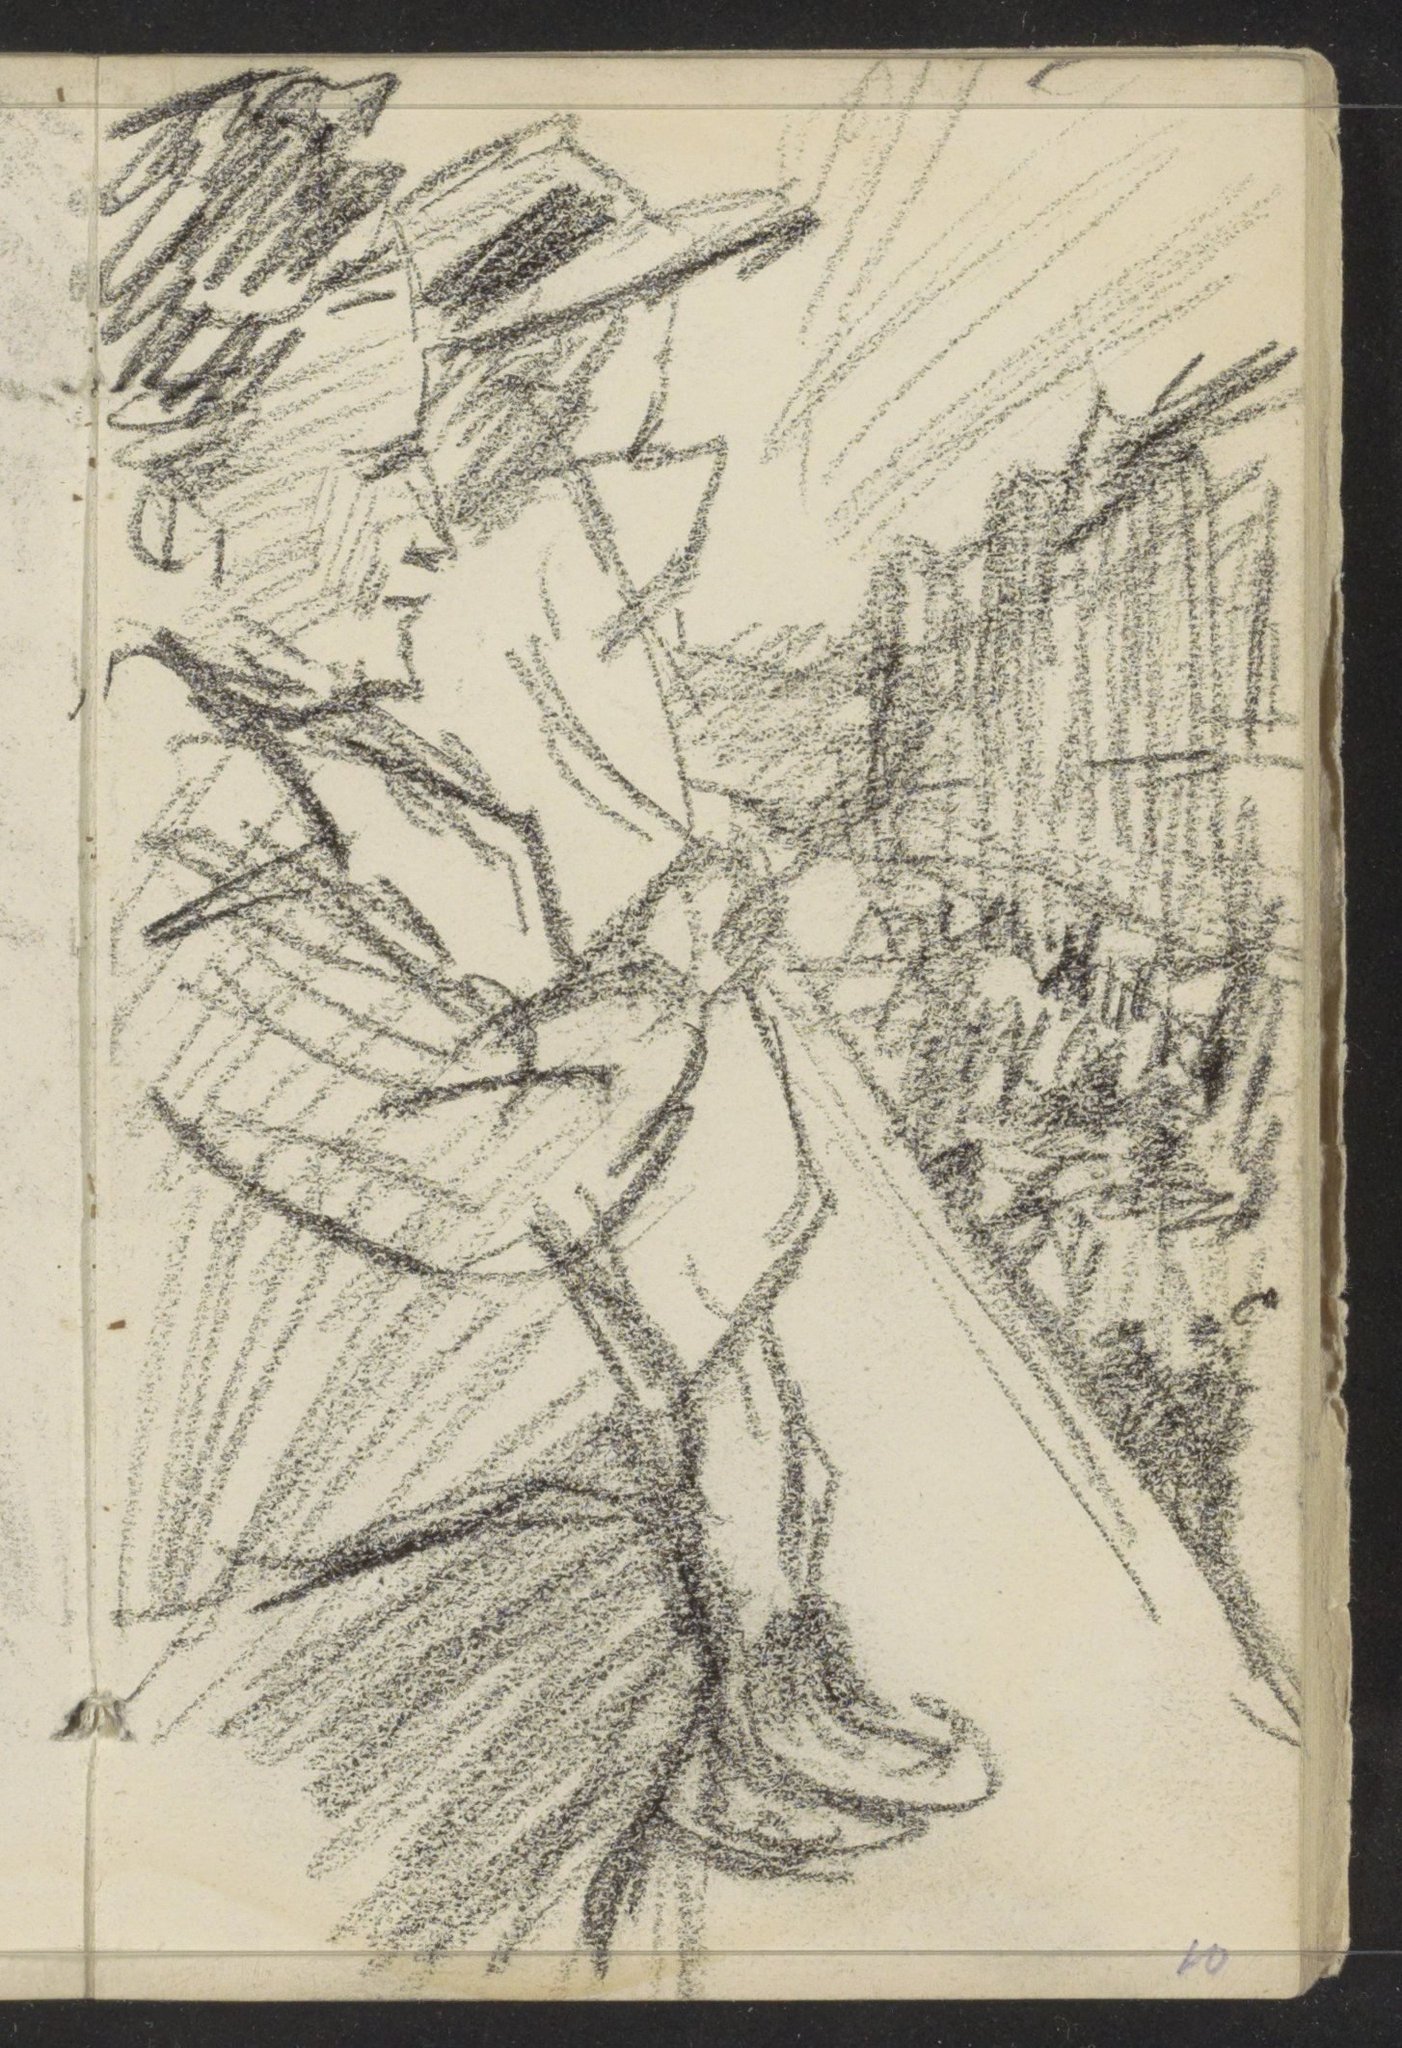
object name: sketchbook leaf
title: Vrouw met een meisje op een balkon in Parijs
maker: isaac israels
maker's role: draughtsman, painter, print maker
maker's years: 1865-1934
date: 1887-1934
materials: chalk, paper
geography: paris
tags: adult woman, girl (child between toddler and youth), balcony, street (+ city(-scape) with figures, staffage), paris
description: Ze kijken naar het verkeer op straat. Mogelijk nabij het Place de la Concorde. Blad 10 recto uit schetsboek LIX met 21 bladen.